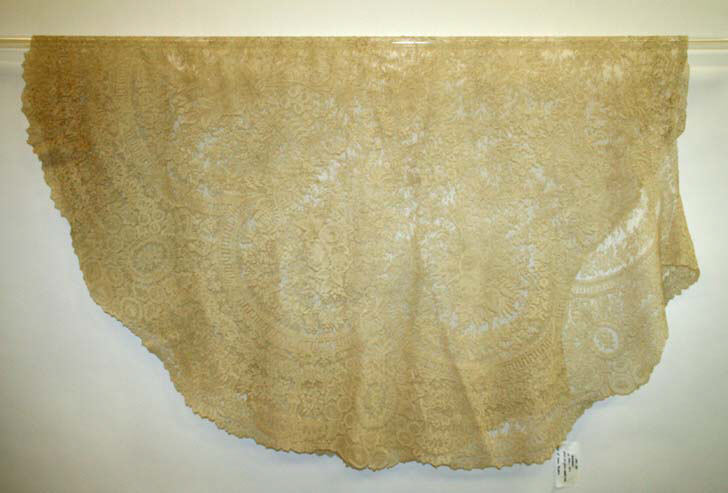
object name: wedding veil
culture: european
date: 1870-1890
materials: cotton